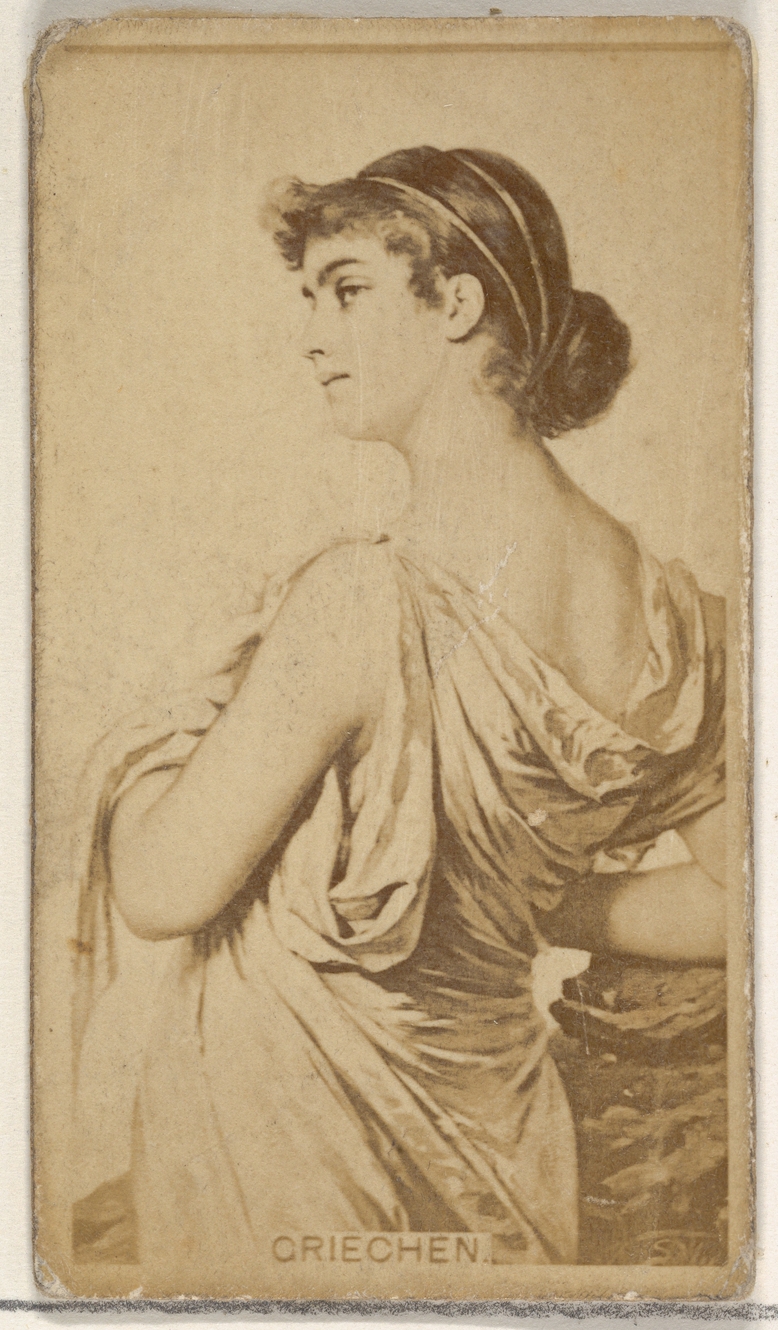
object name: photograph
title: Griechen, from the Actors and Actresses series (N45, Type 8) for Virginia Brights Cigarettes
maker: allen & ginter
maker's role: publisher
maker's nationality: american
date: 1888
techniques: albumen silver print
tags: women,actresses